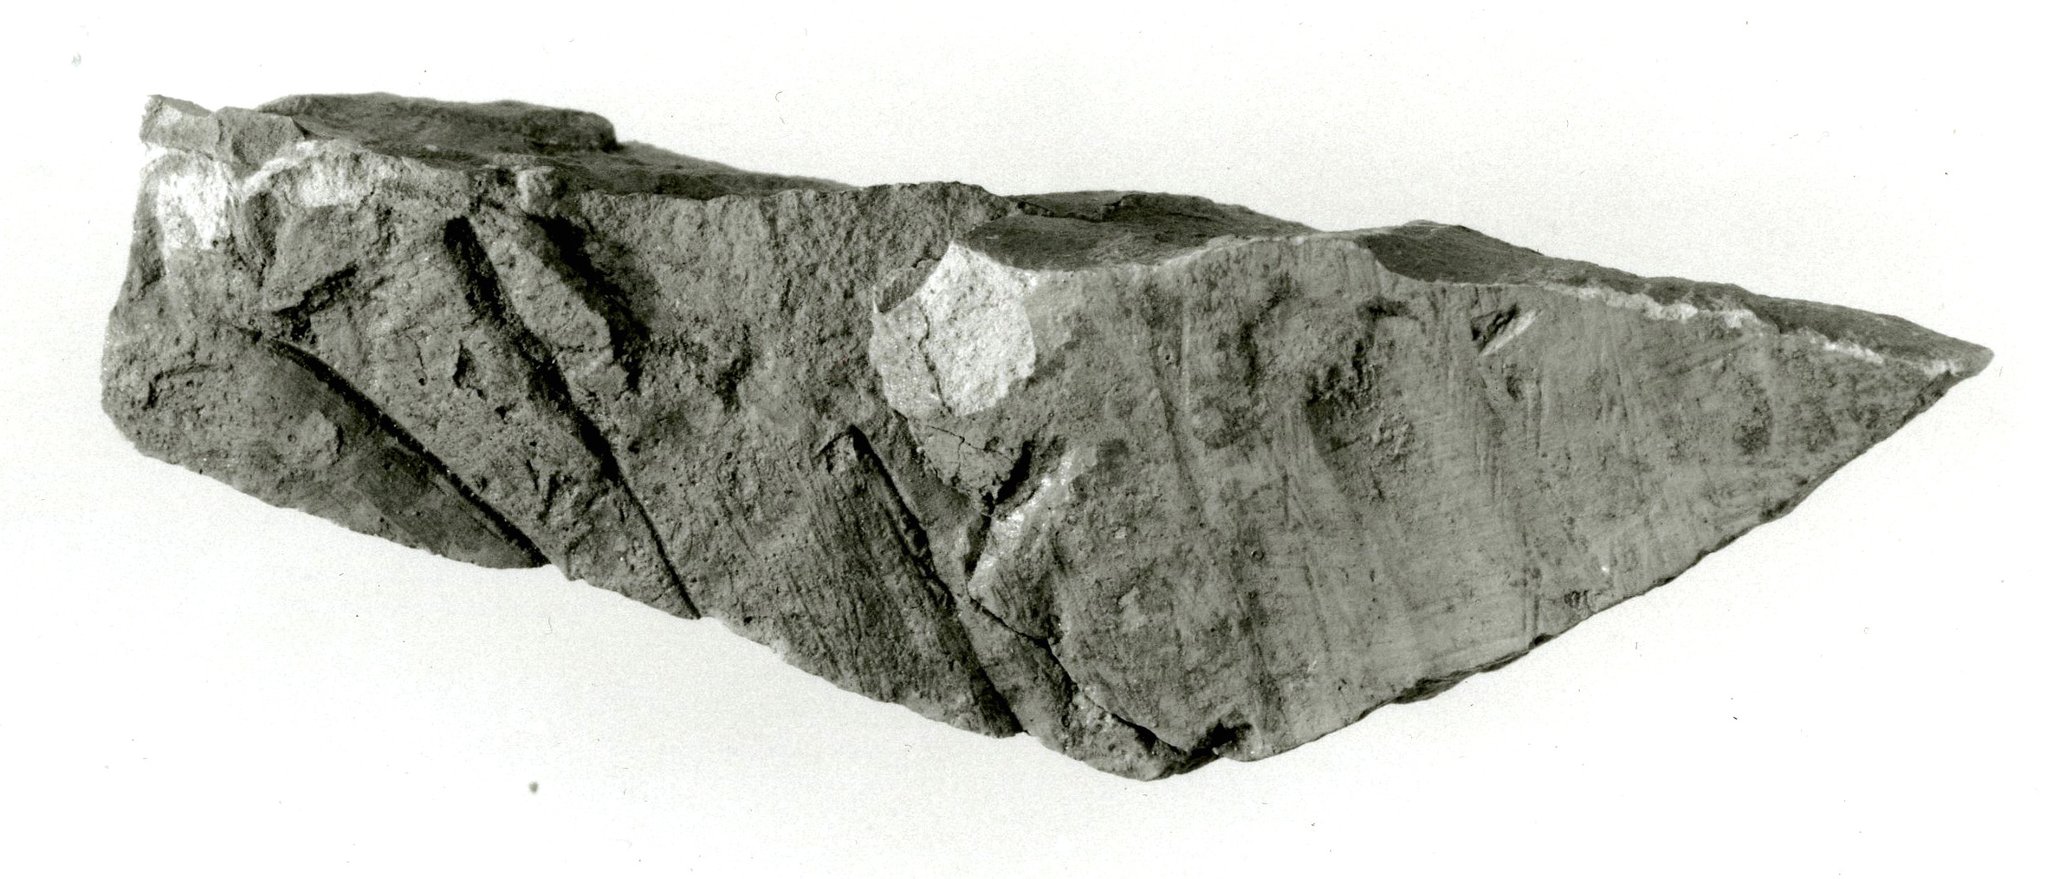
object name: relief, tomb of nespekashuty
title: Sunk relief fragment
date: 664-610 BCE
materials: limestone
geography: egypt